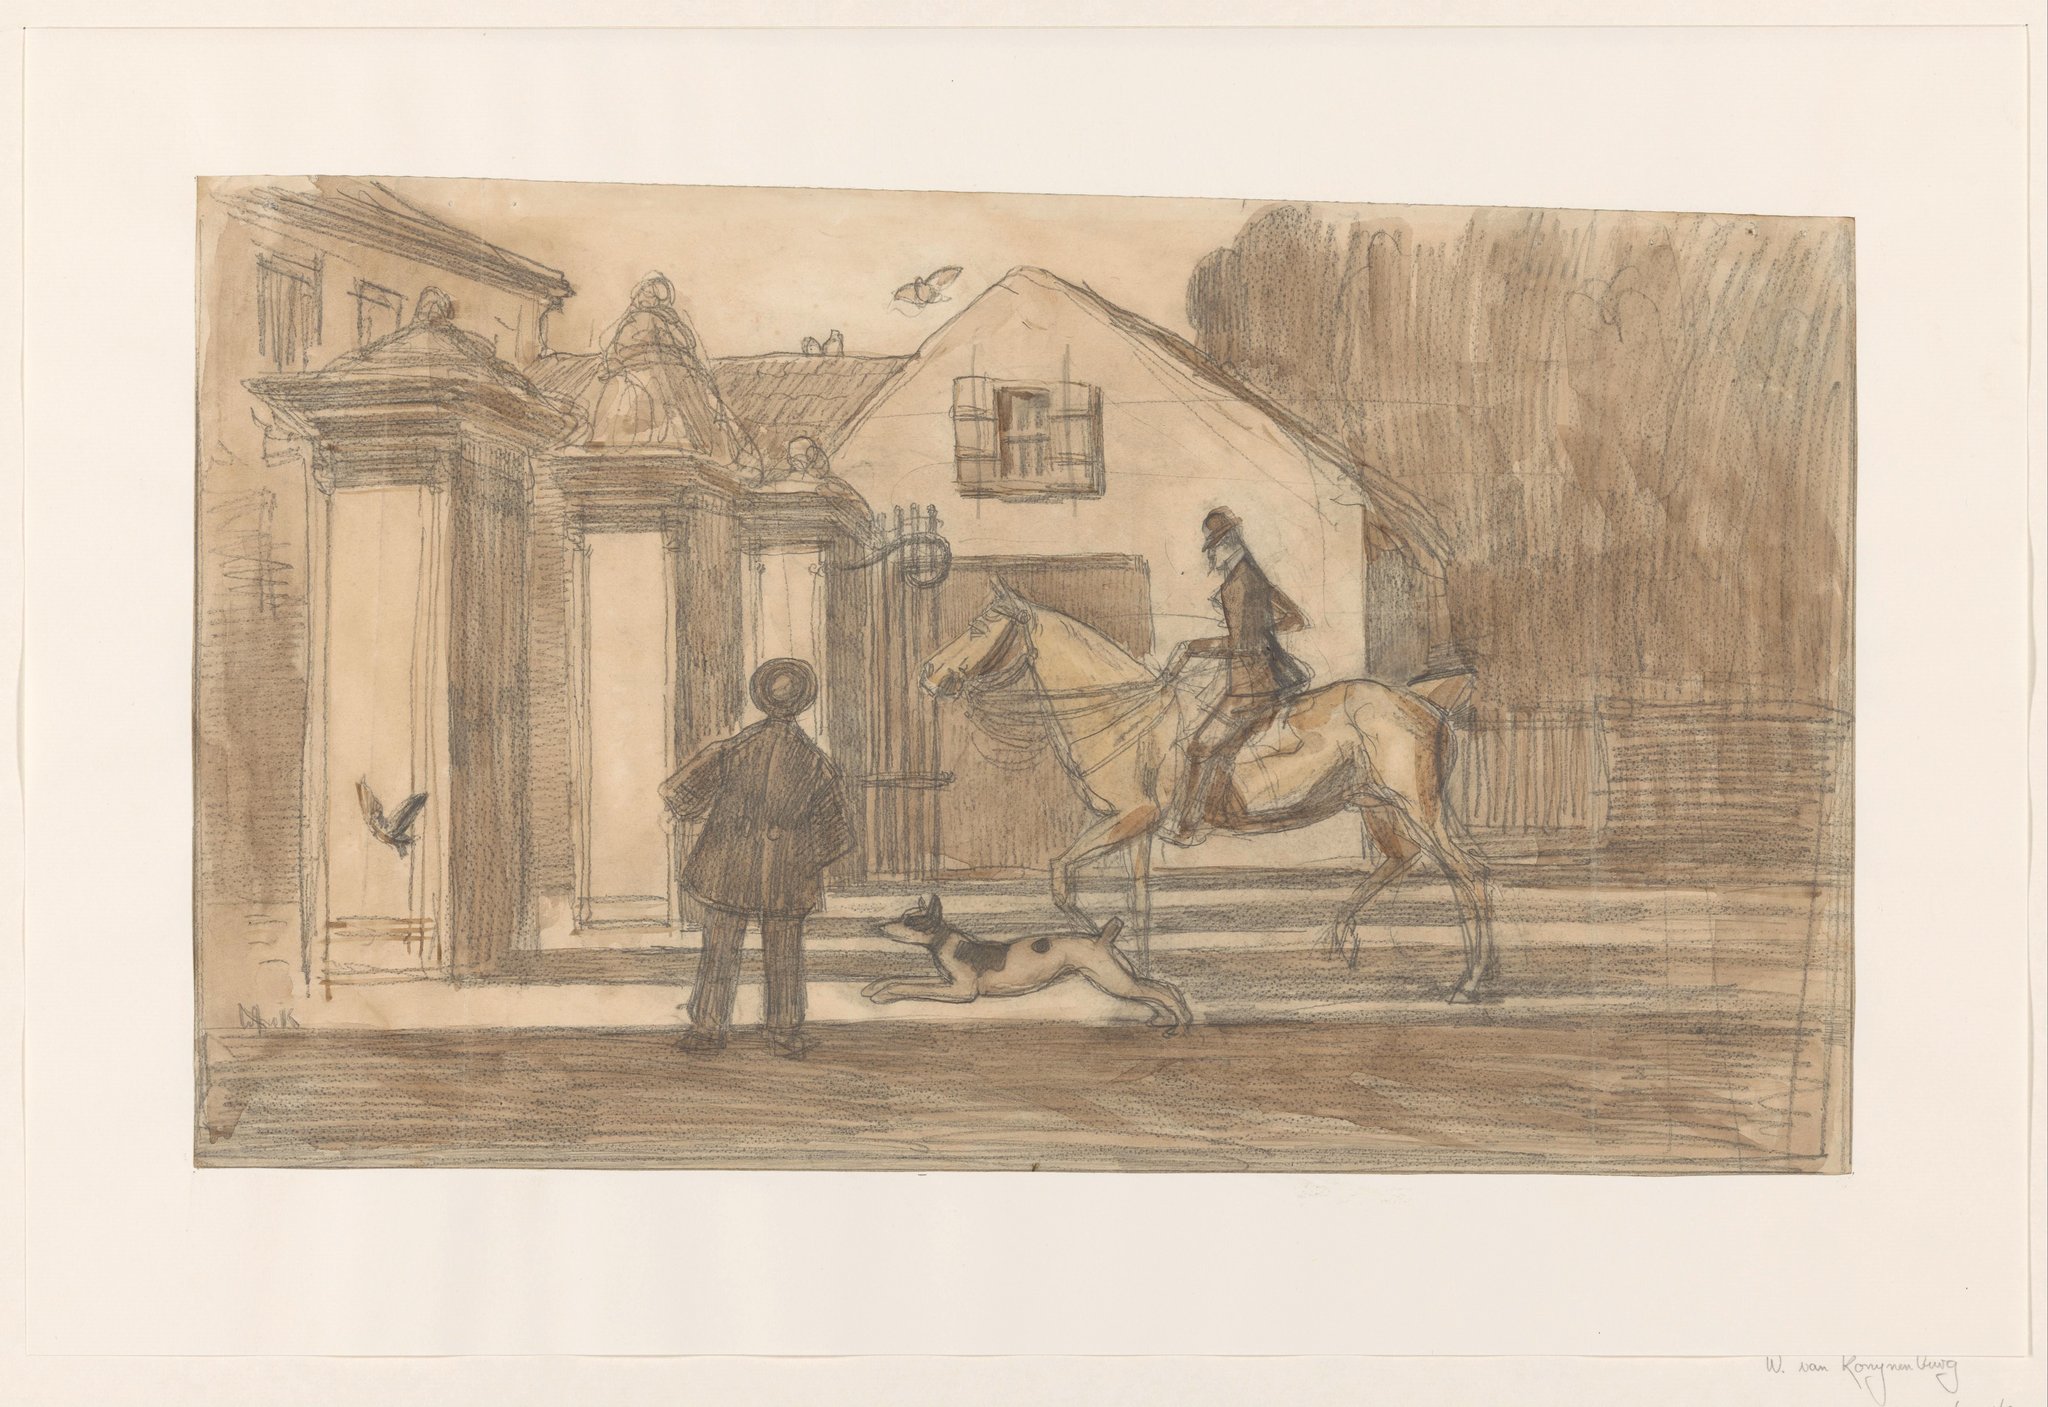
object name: drawing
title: Het hek op de Scheveningse Weg te Den Haag; een ruiter met hond passeren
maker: willem van konijnenburg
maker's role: draughtsman, painter, print maker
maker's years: 1868-1943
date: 1878-1943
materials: paper, pencil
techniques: brush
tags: landscapes, the hague